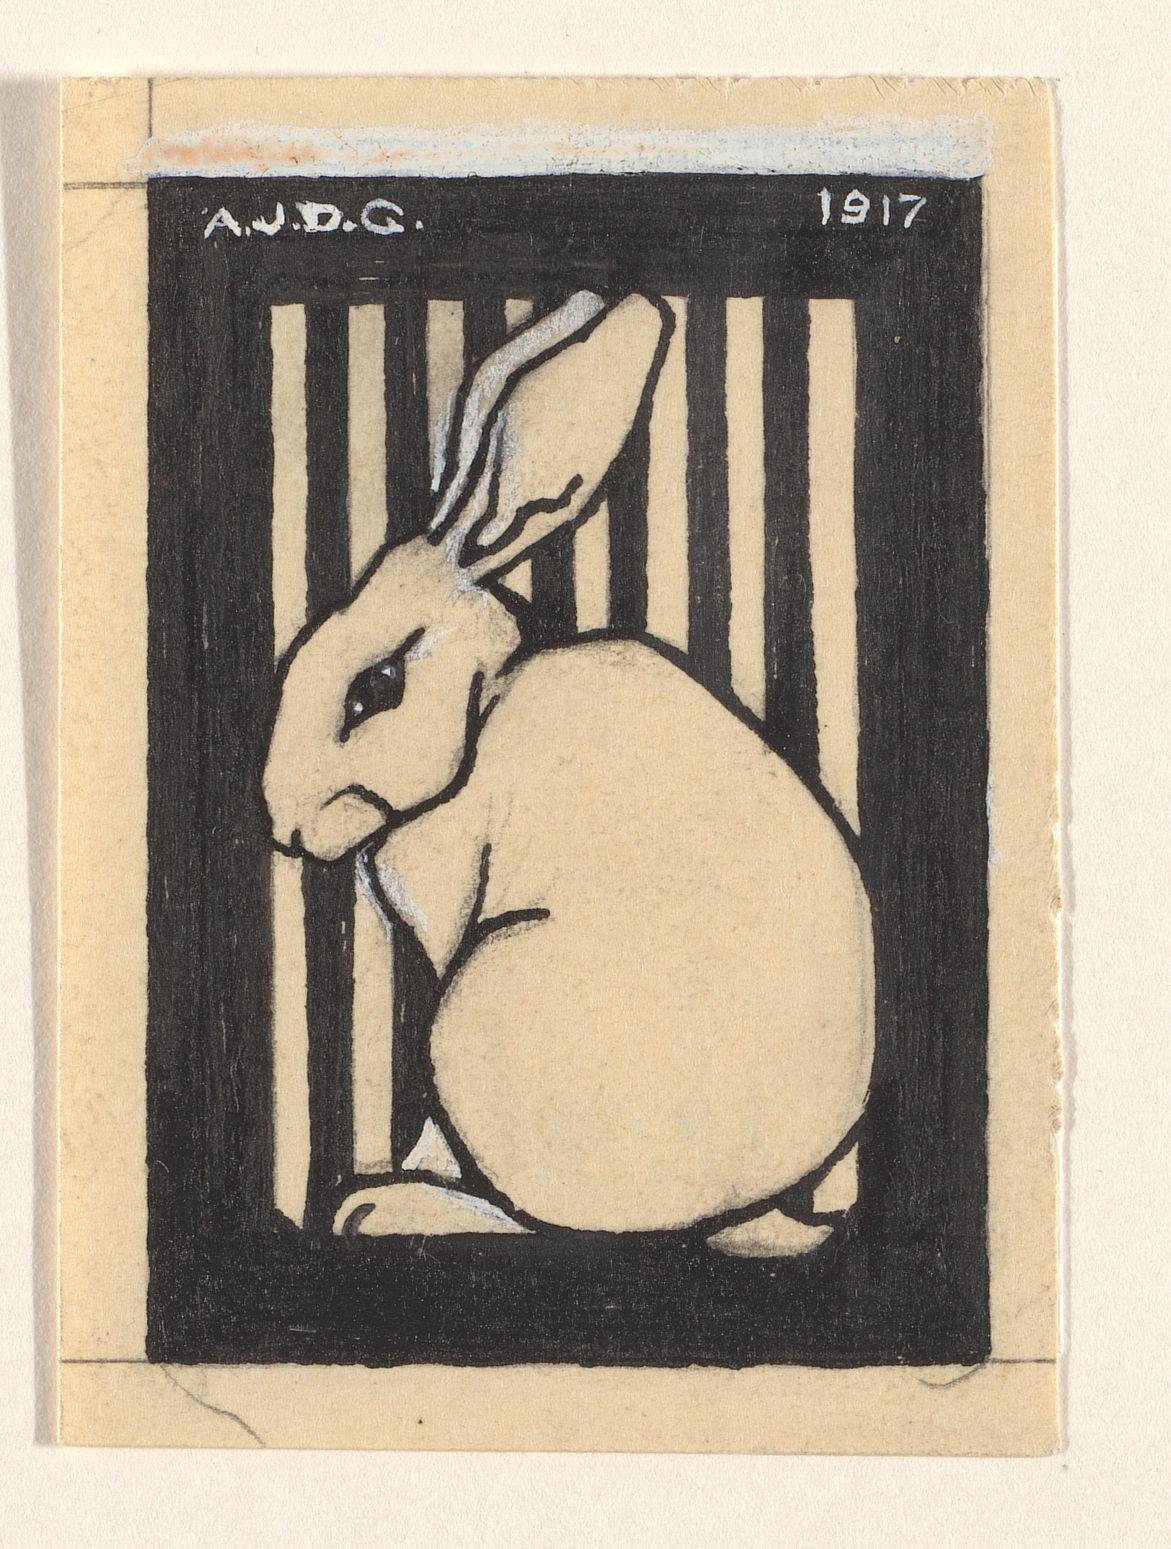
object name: drawing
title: Konijn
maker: julie de graag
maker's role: draughtsman, print maker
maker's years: 1877-1924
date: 1917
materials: paint, ink, paper, pencil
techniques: brush, pen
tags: rodents: rabbit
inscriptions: number: ‘44’, annotation: ‘1/8 gr’